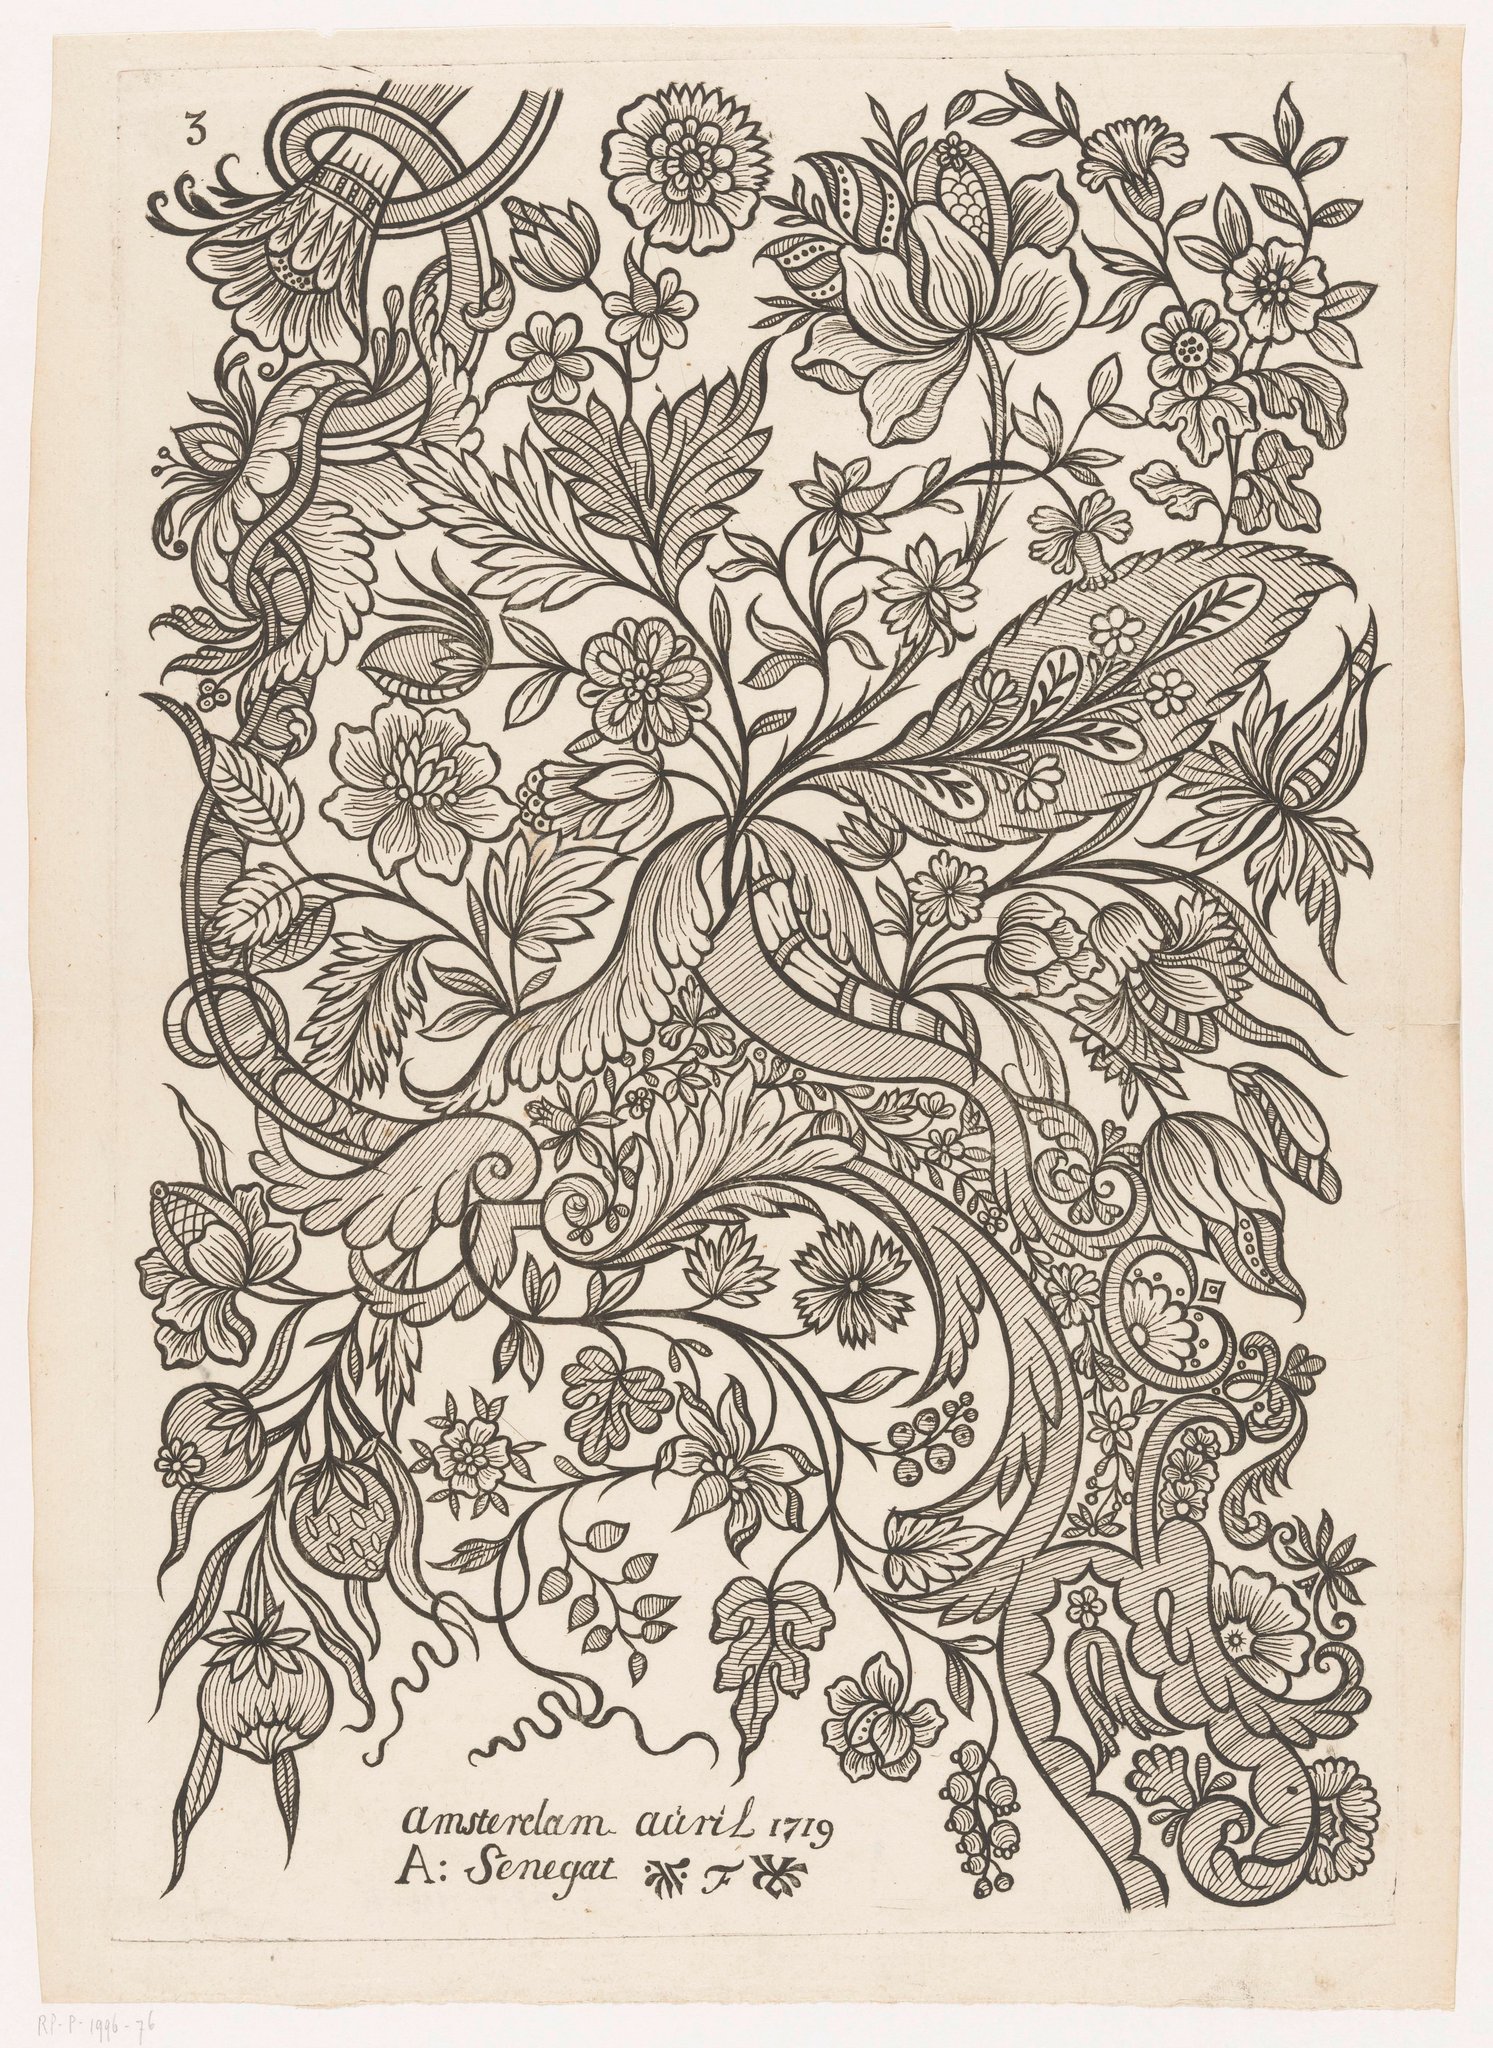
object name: print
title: Ontwerp voor textiel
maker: alexander senegat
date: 1704-1719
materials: paper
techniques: etching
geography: amsterdam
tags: artist (in general) making preliminary designs, sketching, textile industry and clothing industry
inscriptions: collector's mark: Lugt 2760, collector's mark: Lugt 2228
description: Ontwerp voor textiel met fantasiebloemen en -bladeren.